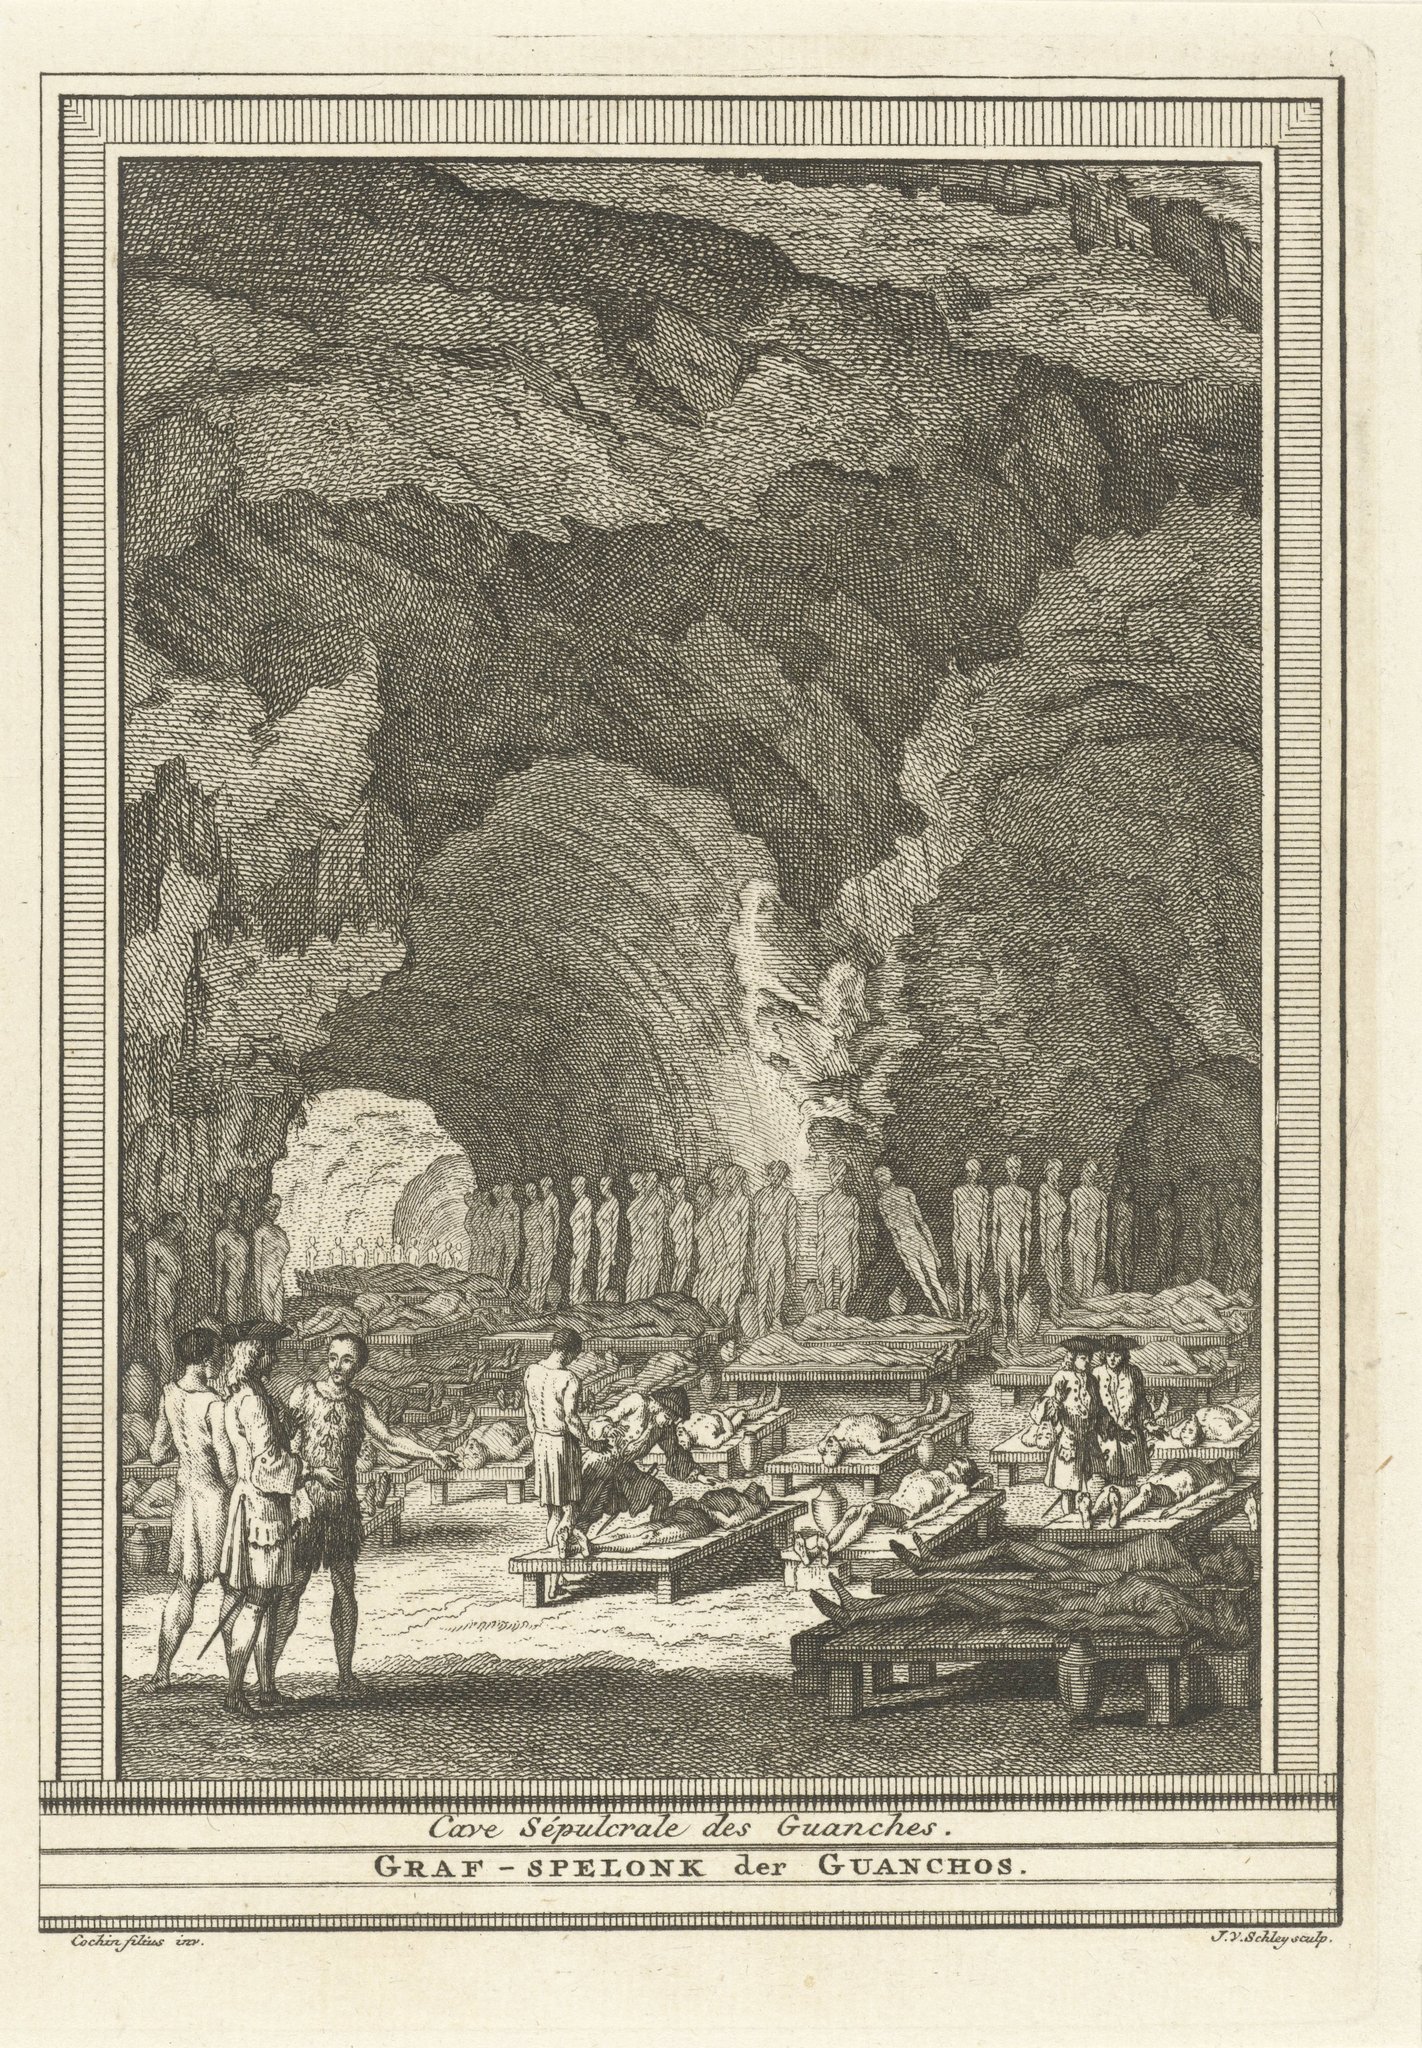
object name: print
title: Cave sépulcrale des Guanches / Grafspelonk der Guanchos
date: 1749-1779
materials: paper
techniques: engraving, etching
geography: amsterdam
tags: mummy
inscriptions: collector's mark: Lugt 2228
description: Enkele mannen bekijken de grafspelonk met mummies van de oorspronkelijke bewoners van de Canarische Eilanden, ook wel Guanches genoemd.